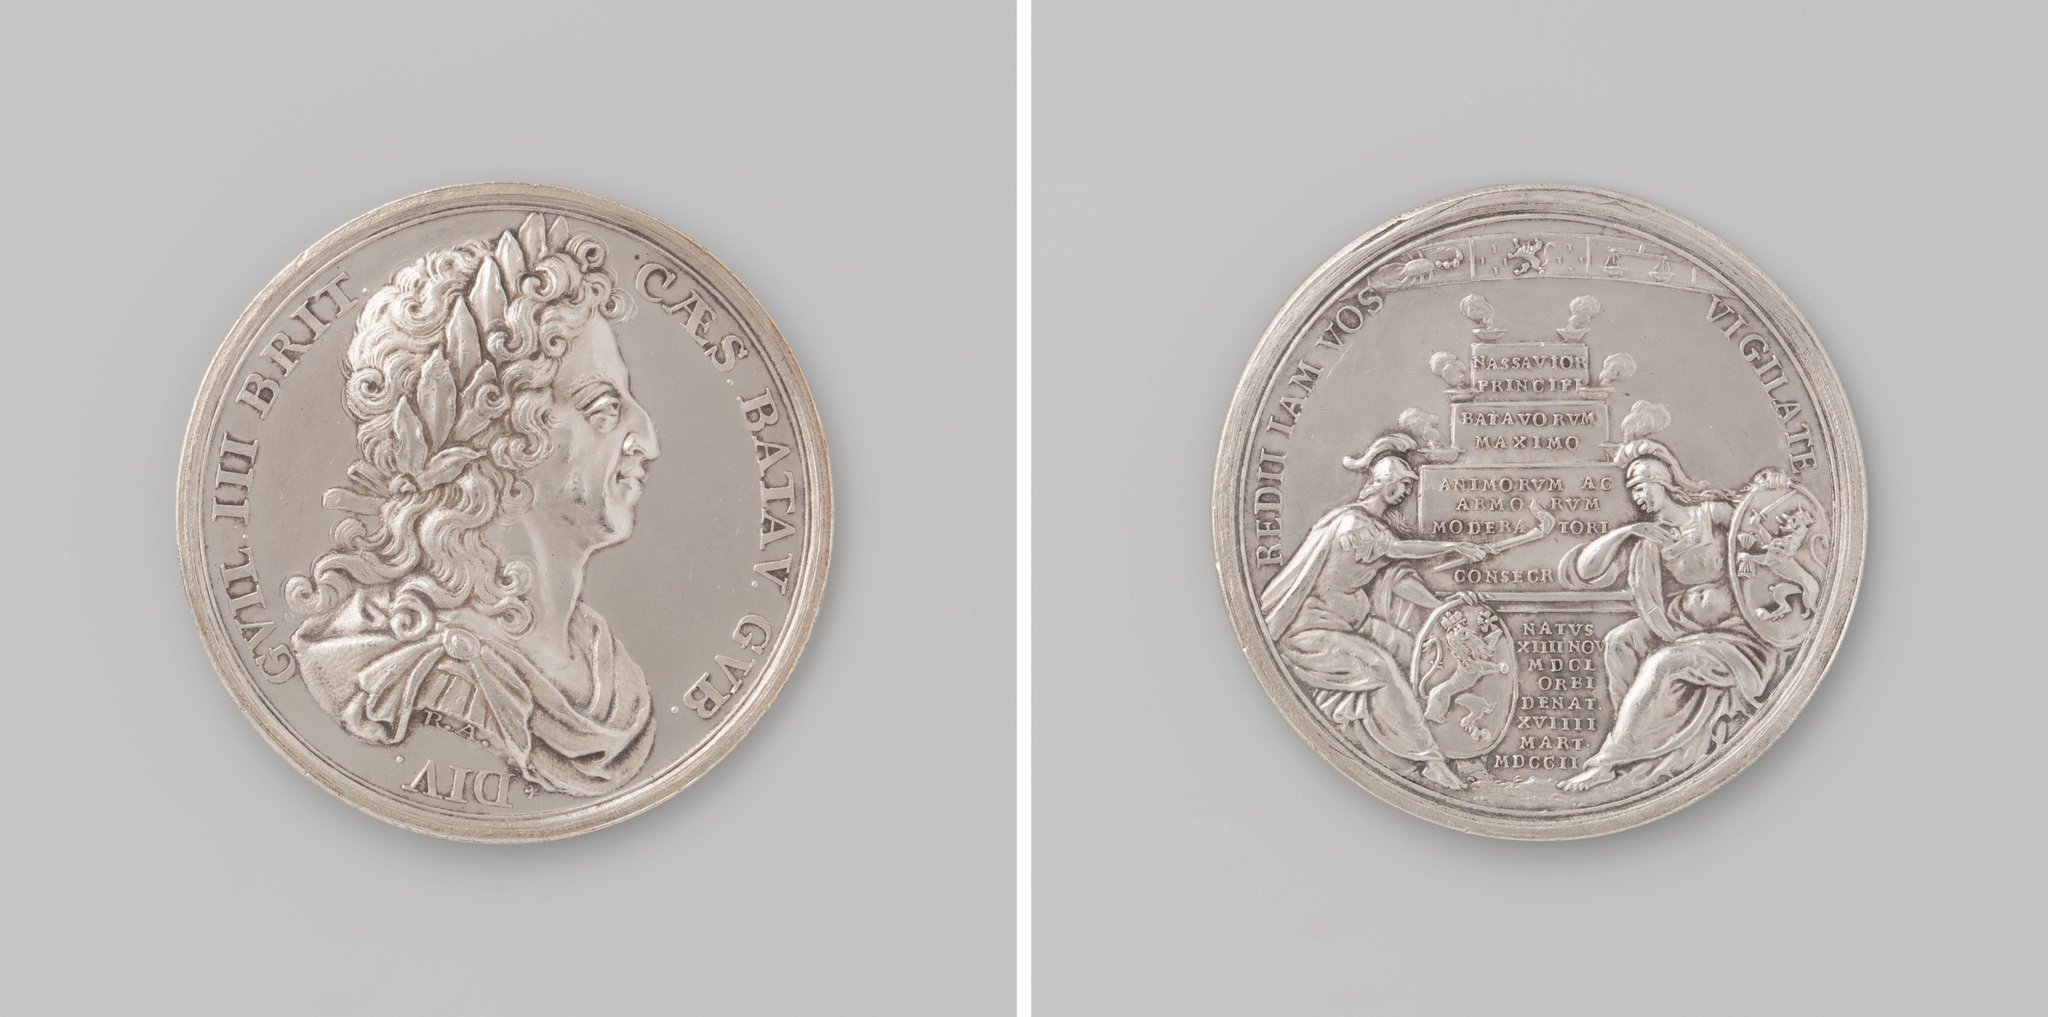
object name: history medal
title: Dood van Willem III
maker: reynier arondeaux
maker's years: 1678-1727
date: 1702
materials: silver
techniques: striking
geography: amsterdam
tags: the hague, william iii (prince of orange and king of england, scotland, and ireland)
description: Zilveren penning. Voorzijde: borststuk man met lauwerkrans binnen omschrift. Keerzijde: Britannia en Holland zittend naast uit grafmonument, opgebouwd uit vier delen, elk met inscriptie binnen omschrift